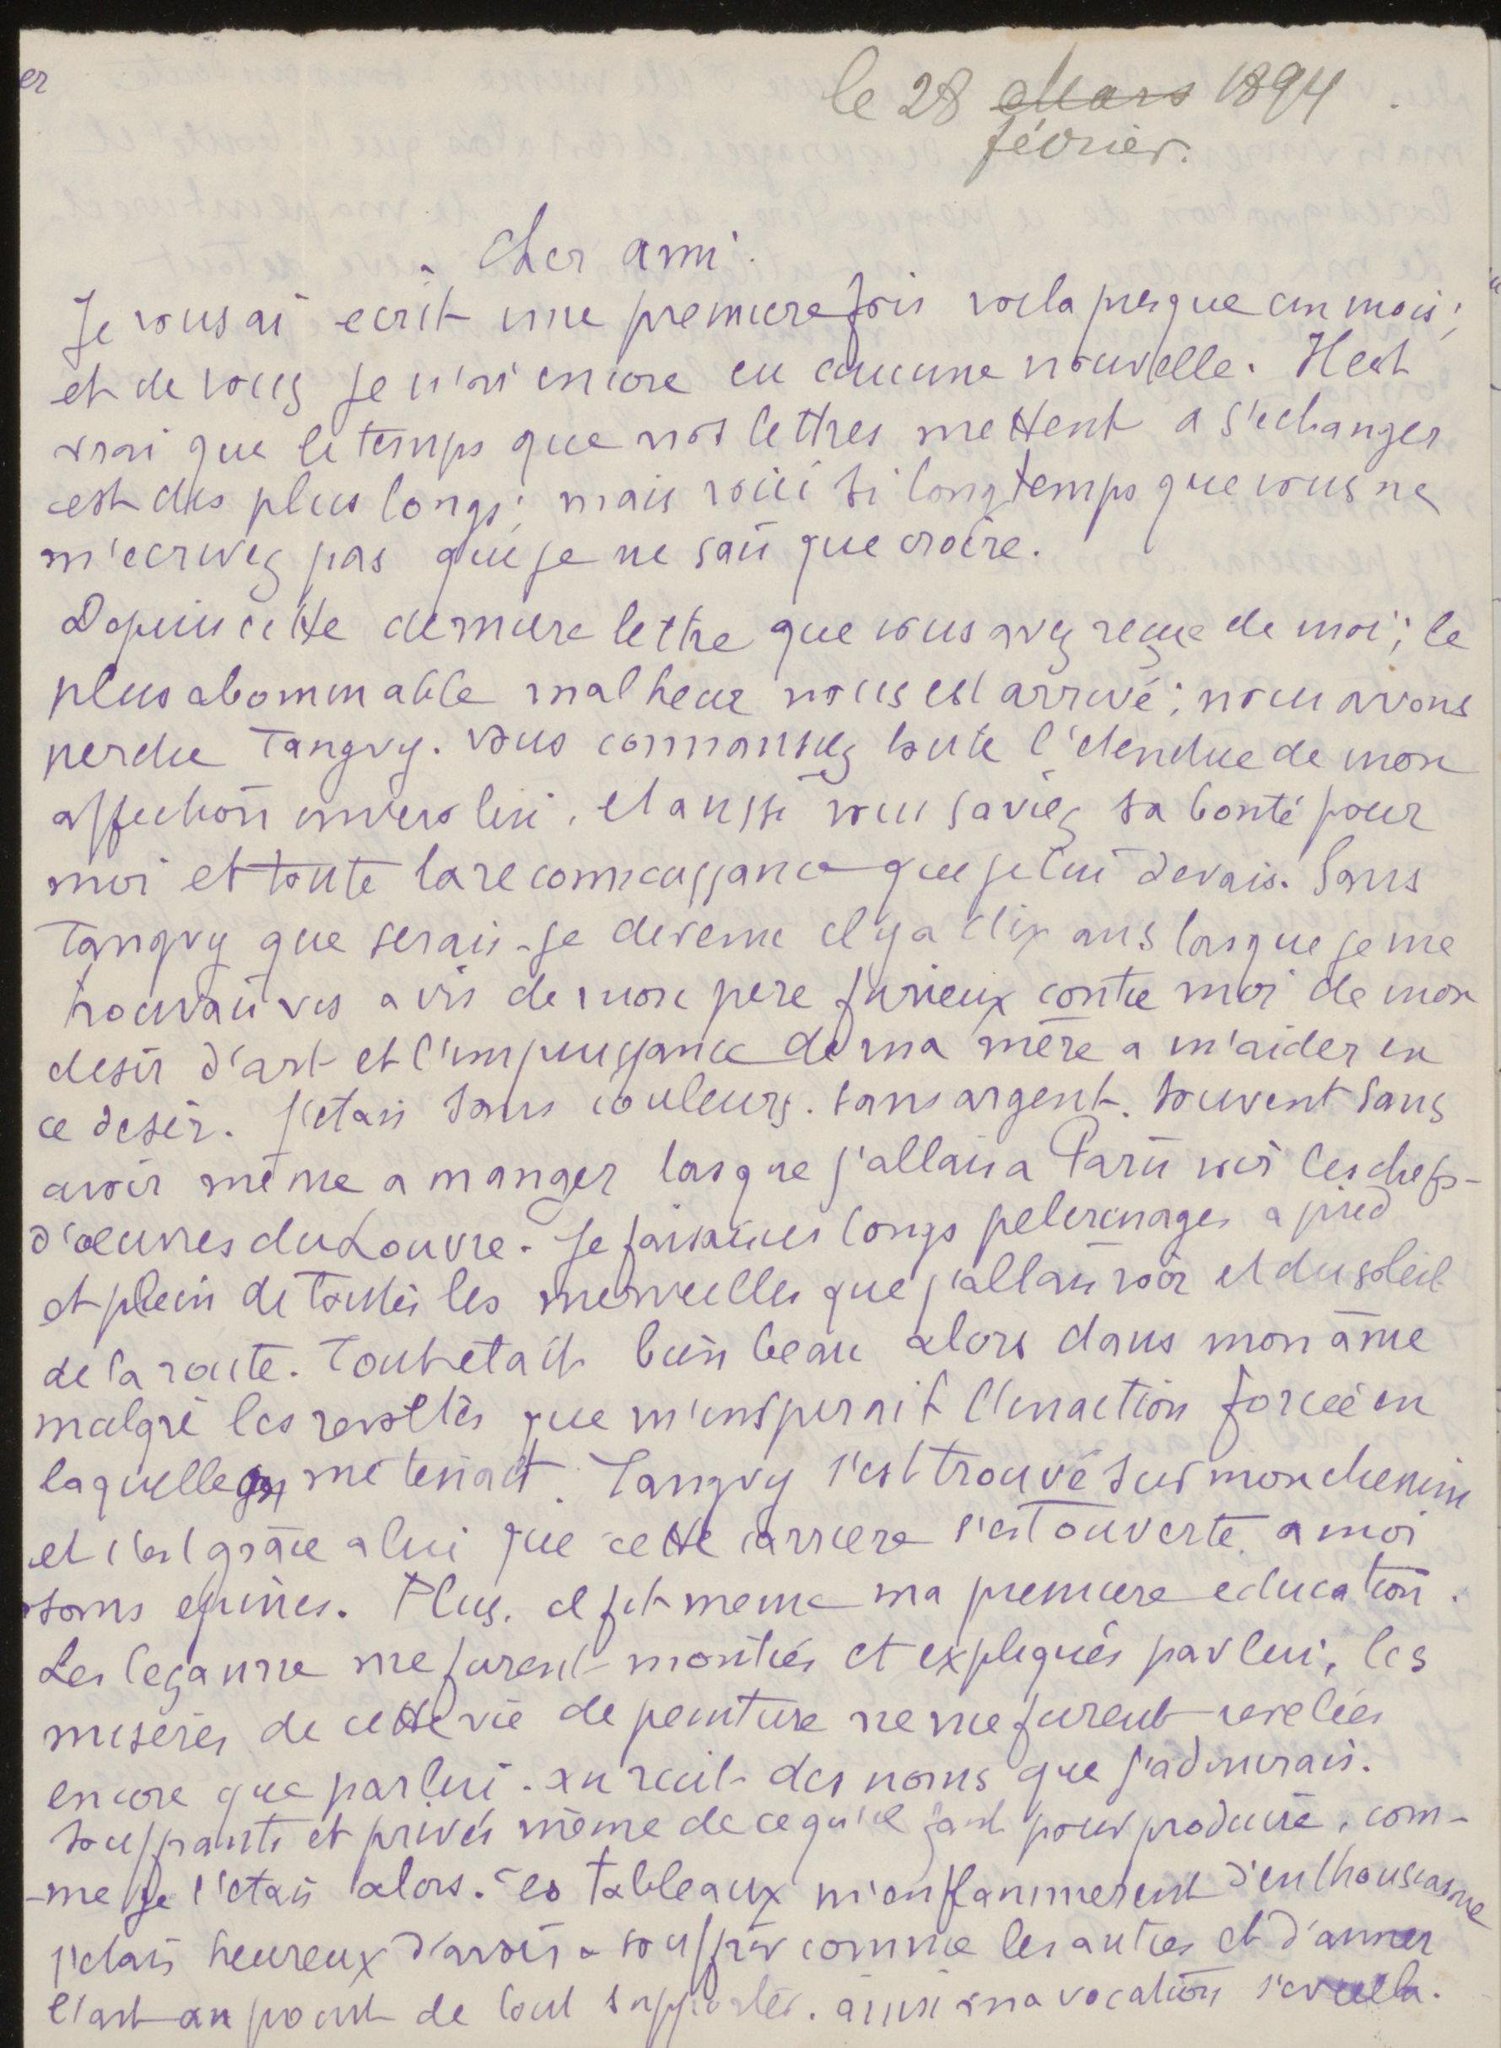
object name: letter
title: Brief aan Andries Bonger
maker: émile bernard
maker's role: print maker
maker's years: 1868-1941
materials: ink, paper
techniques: pen, writing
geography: cairo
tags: paris, copenhagen (city), painter, print maker, draughtsman, vincent van gogh, andries bonger, designer, jan verkade, painting (including book-illumination, miniature-painting), money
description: Gedateerd 28 mars février 1894 in latere hand.